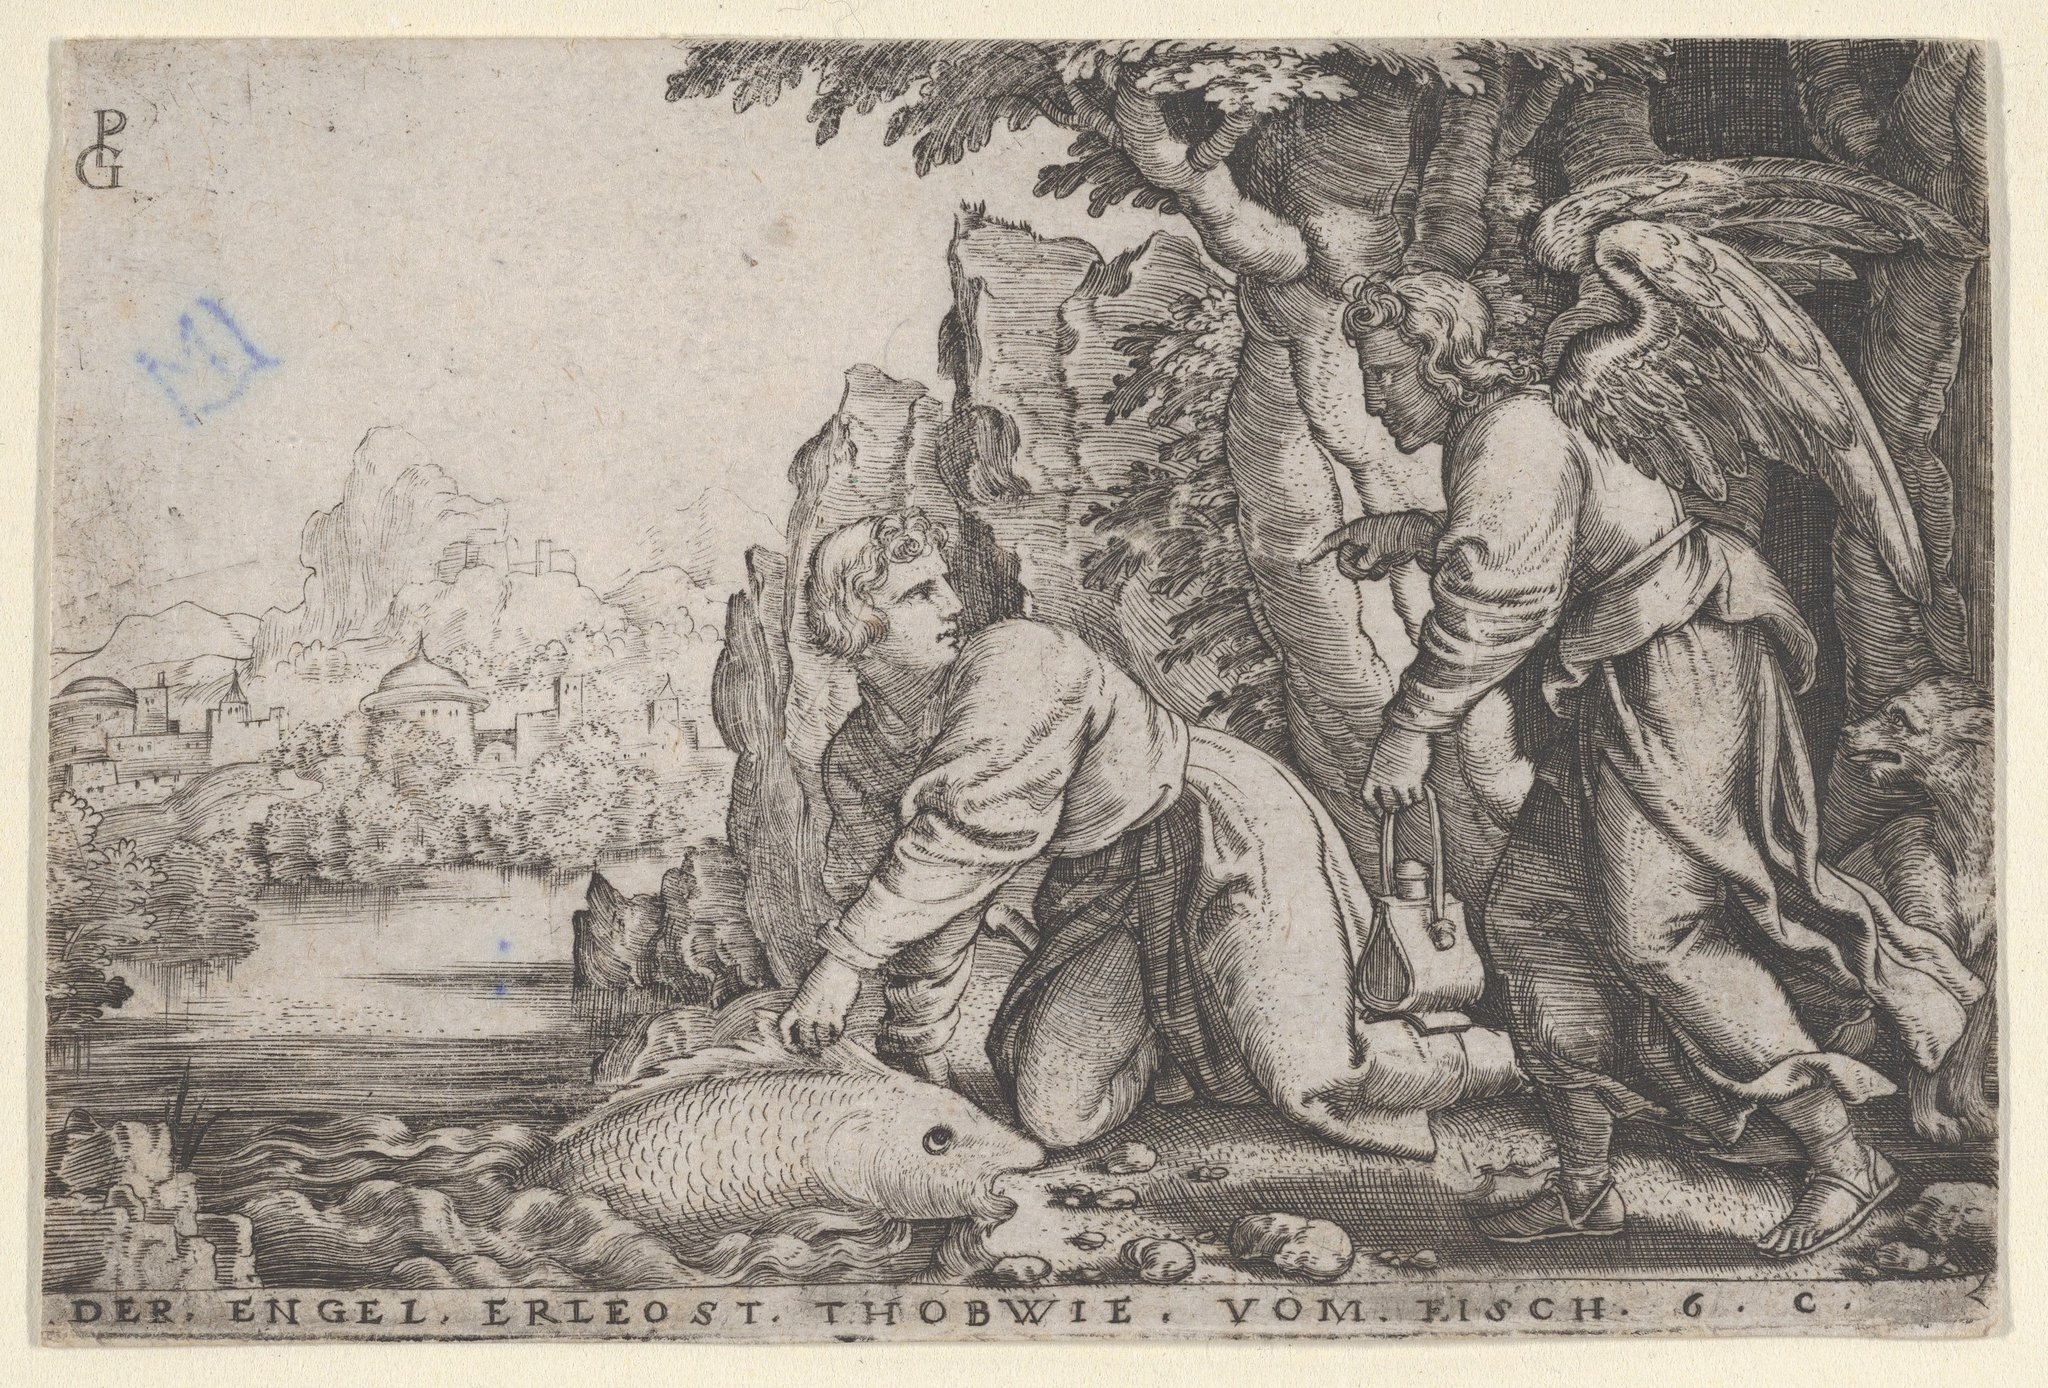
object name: print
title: Tobiolus Catches the Fish, from The Story of Tobias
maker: georg pencz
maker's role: artist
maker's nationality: german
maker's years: 1500-1550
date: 1543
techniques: engraving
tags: men,fish